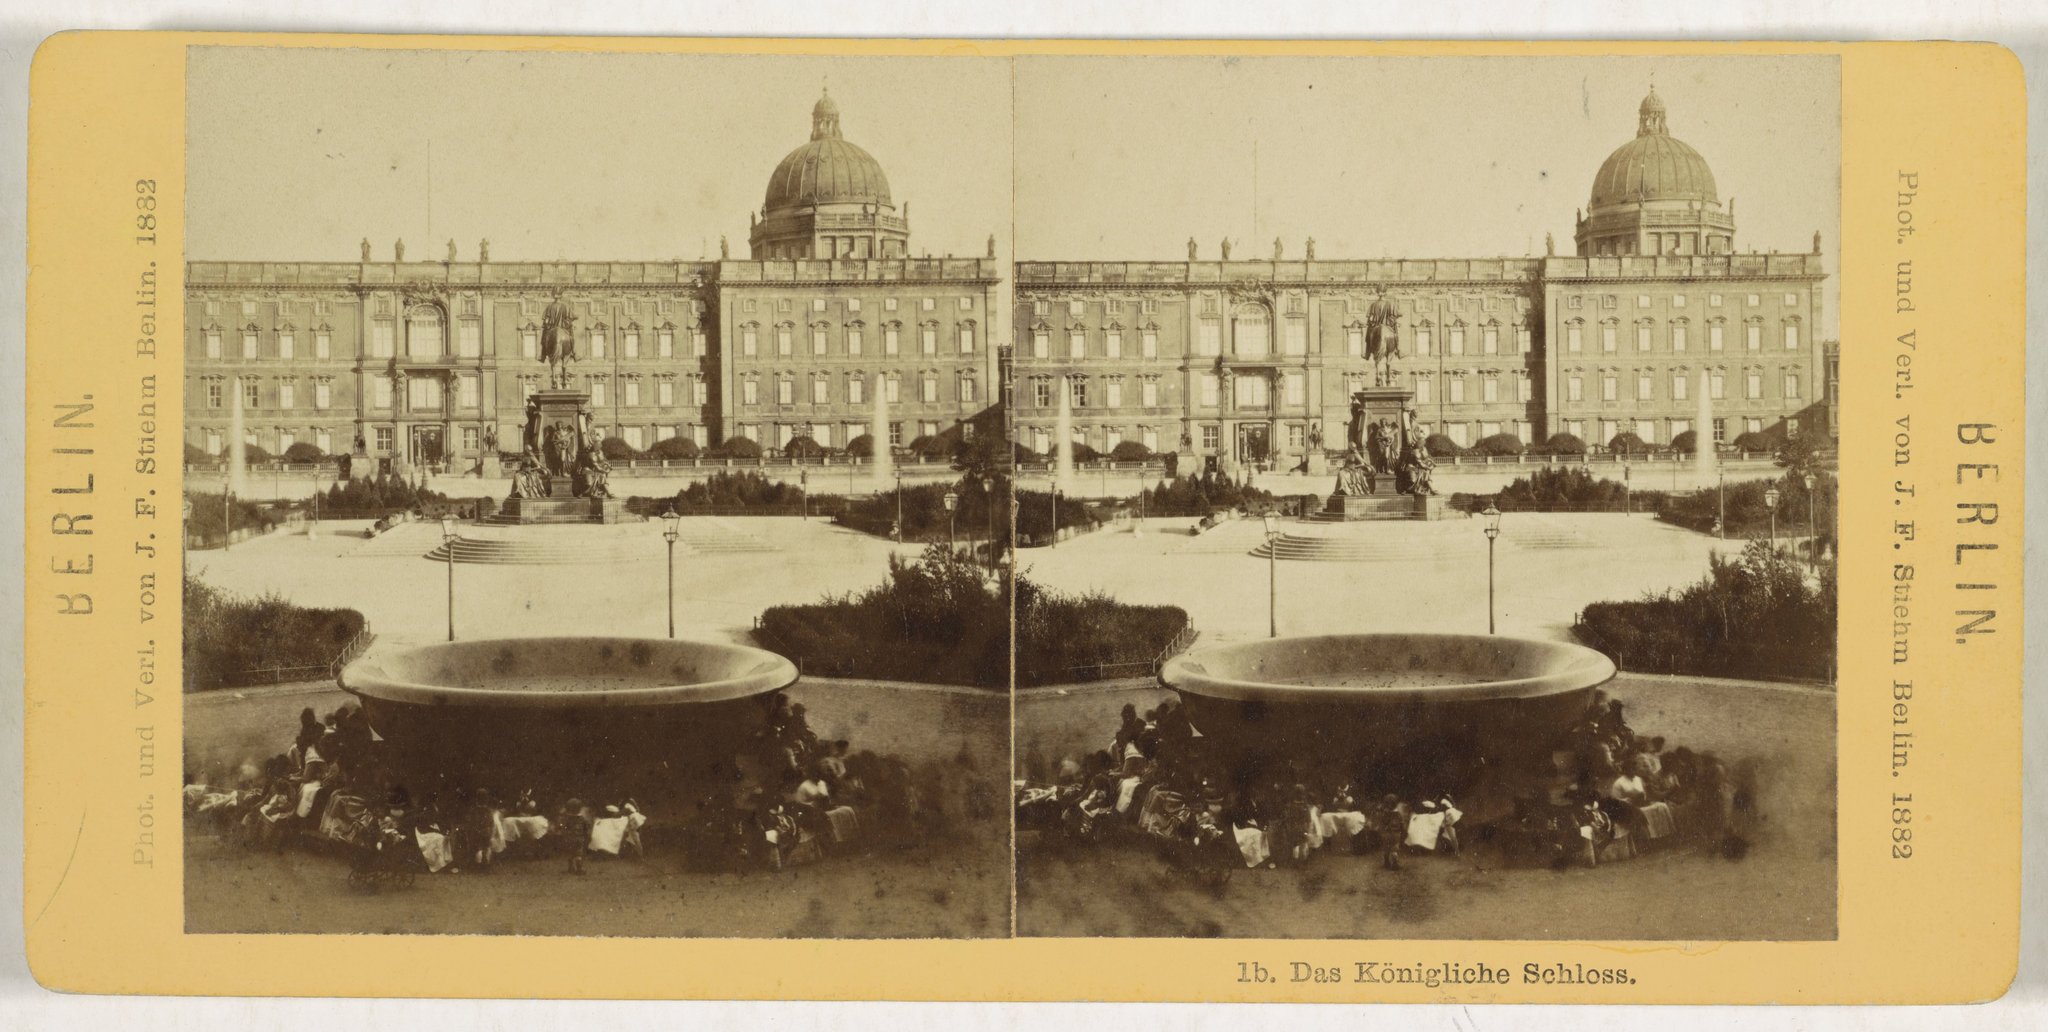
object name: stereograph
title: Berlin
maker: johann friedrich stiehm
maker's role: fotograaf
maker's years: 1826-1902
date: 1882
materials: cardboard, paper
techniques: albumen print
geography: berlin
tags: palace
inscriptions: number: ‘1b.’, number: ‘133’